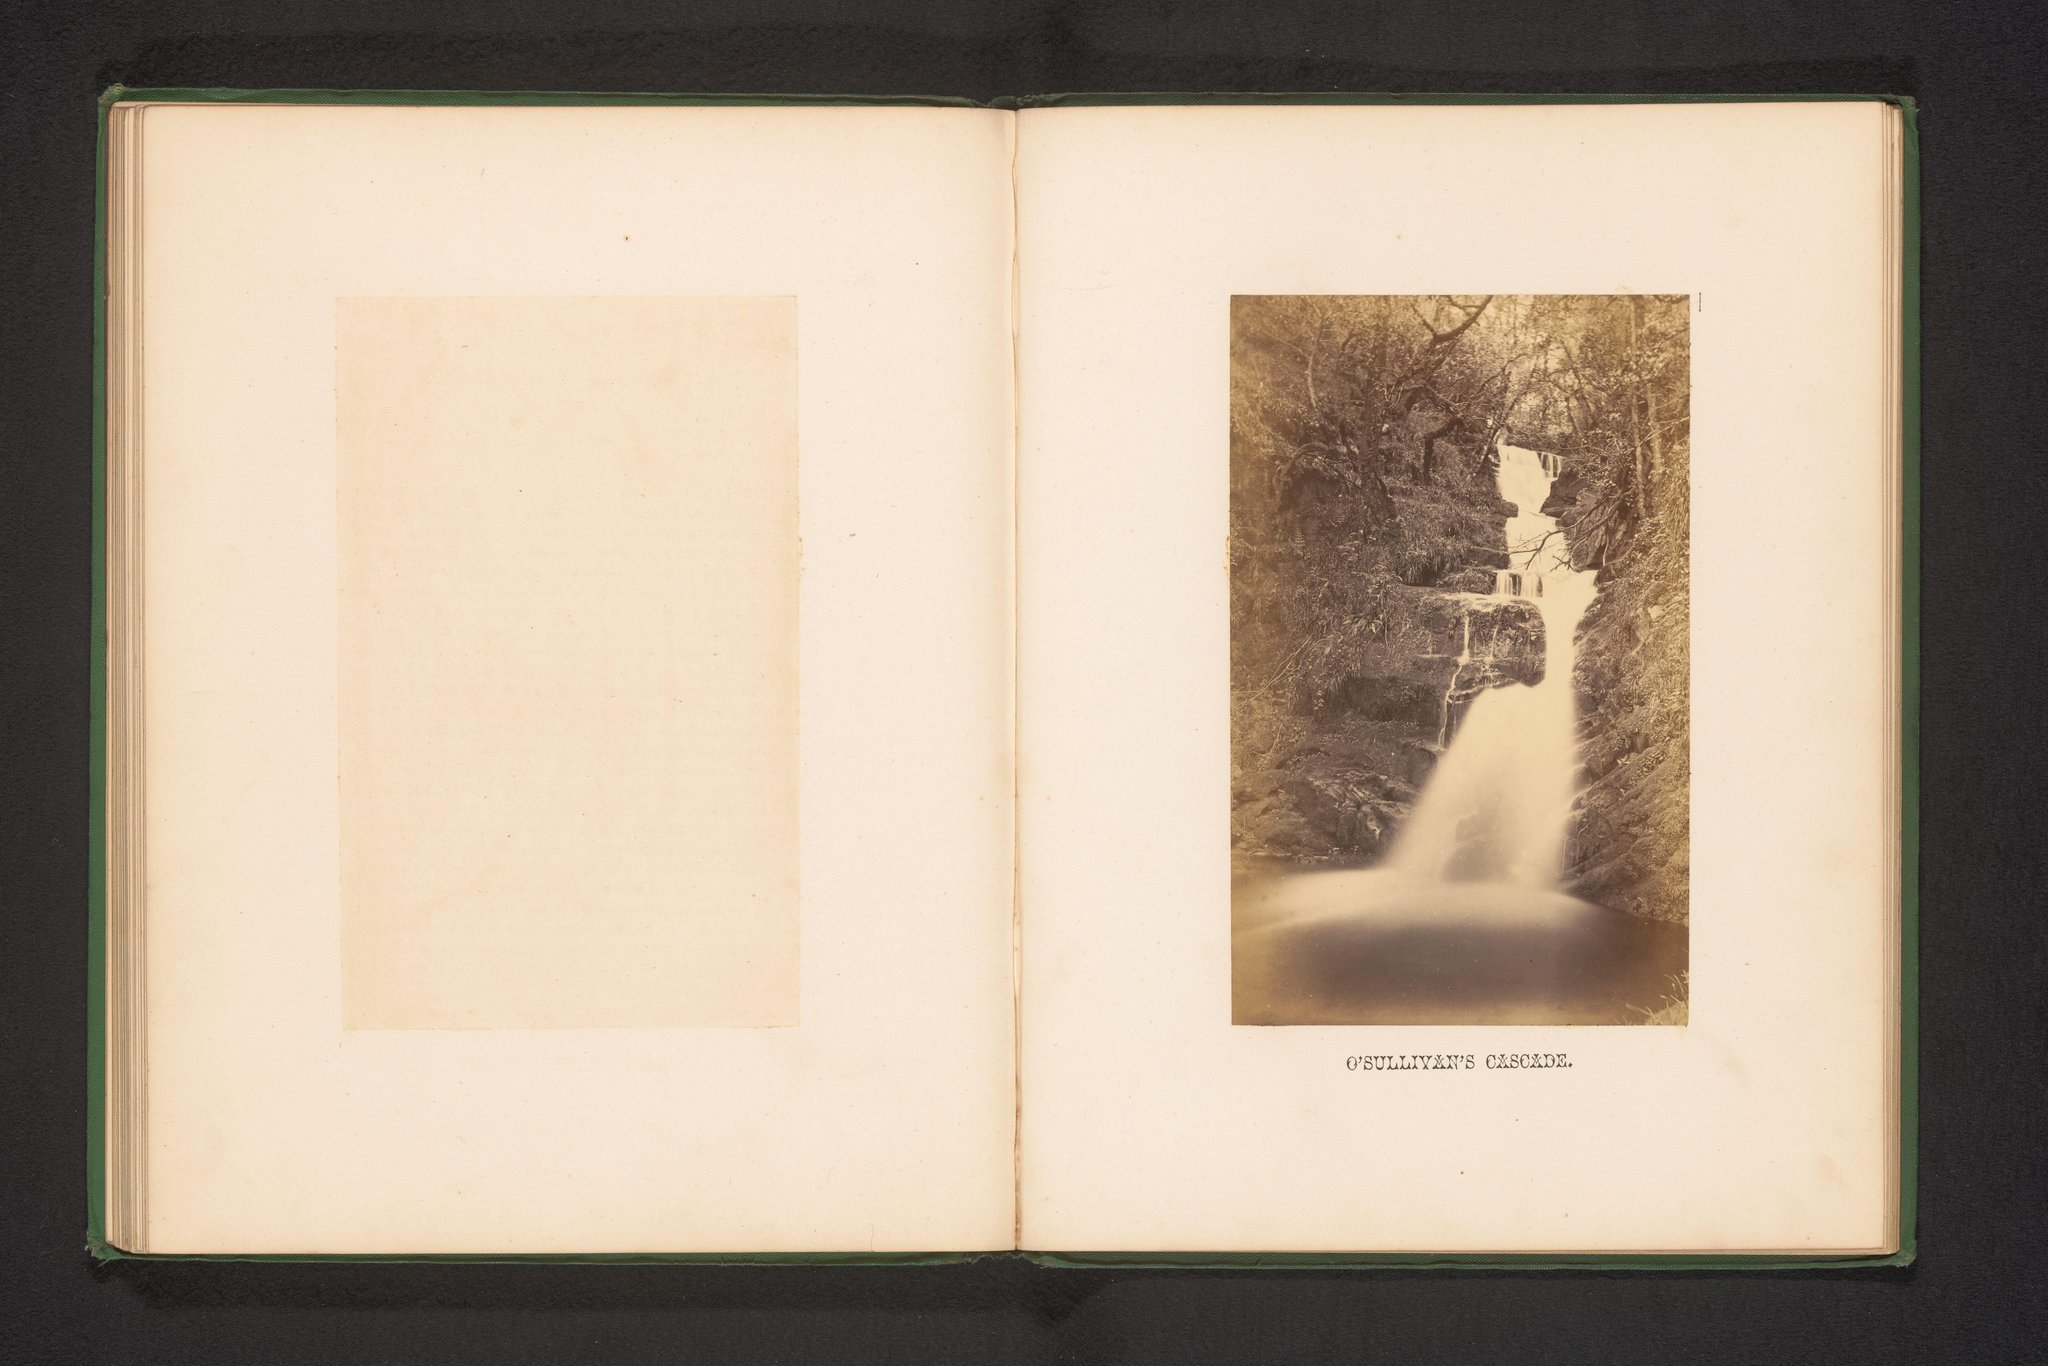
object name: page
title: O'Sullivan's Cascade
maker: john hudson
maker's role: fotograaf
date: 1862-1867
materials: photographic support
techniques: albumen print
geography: killarney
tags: waterfall